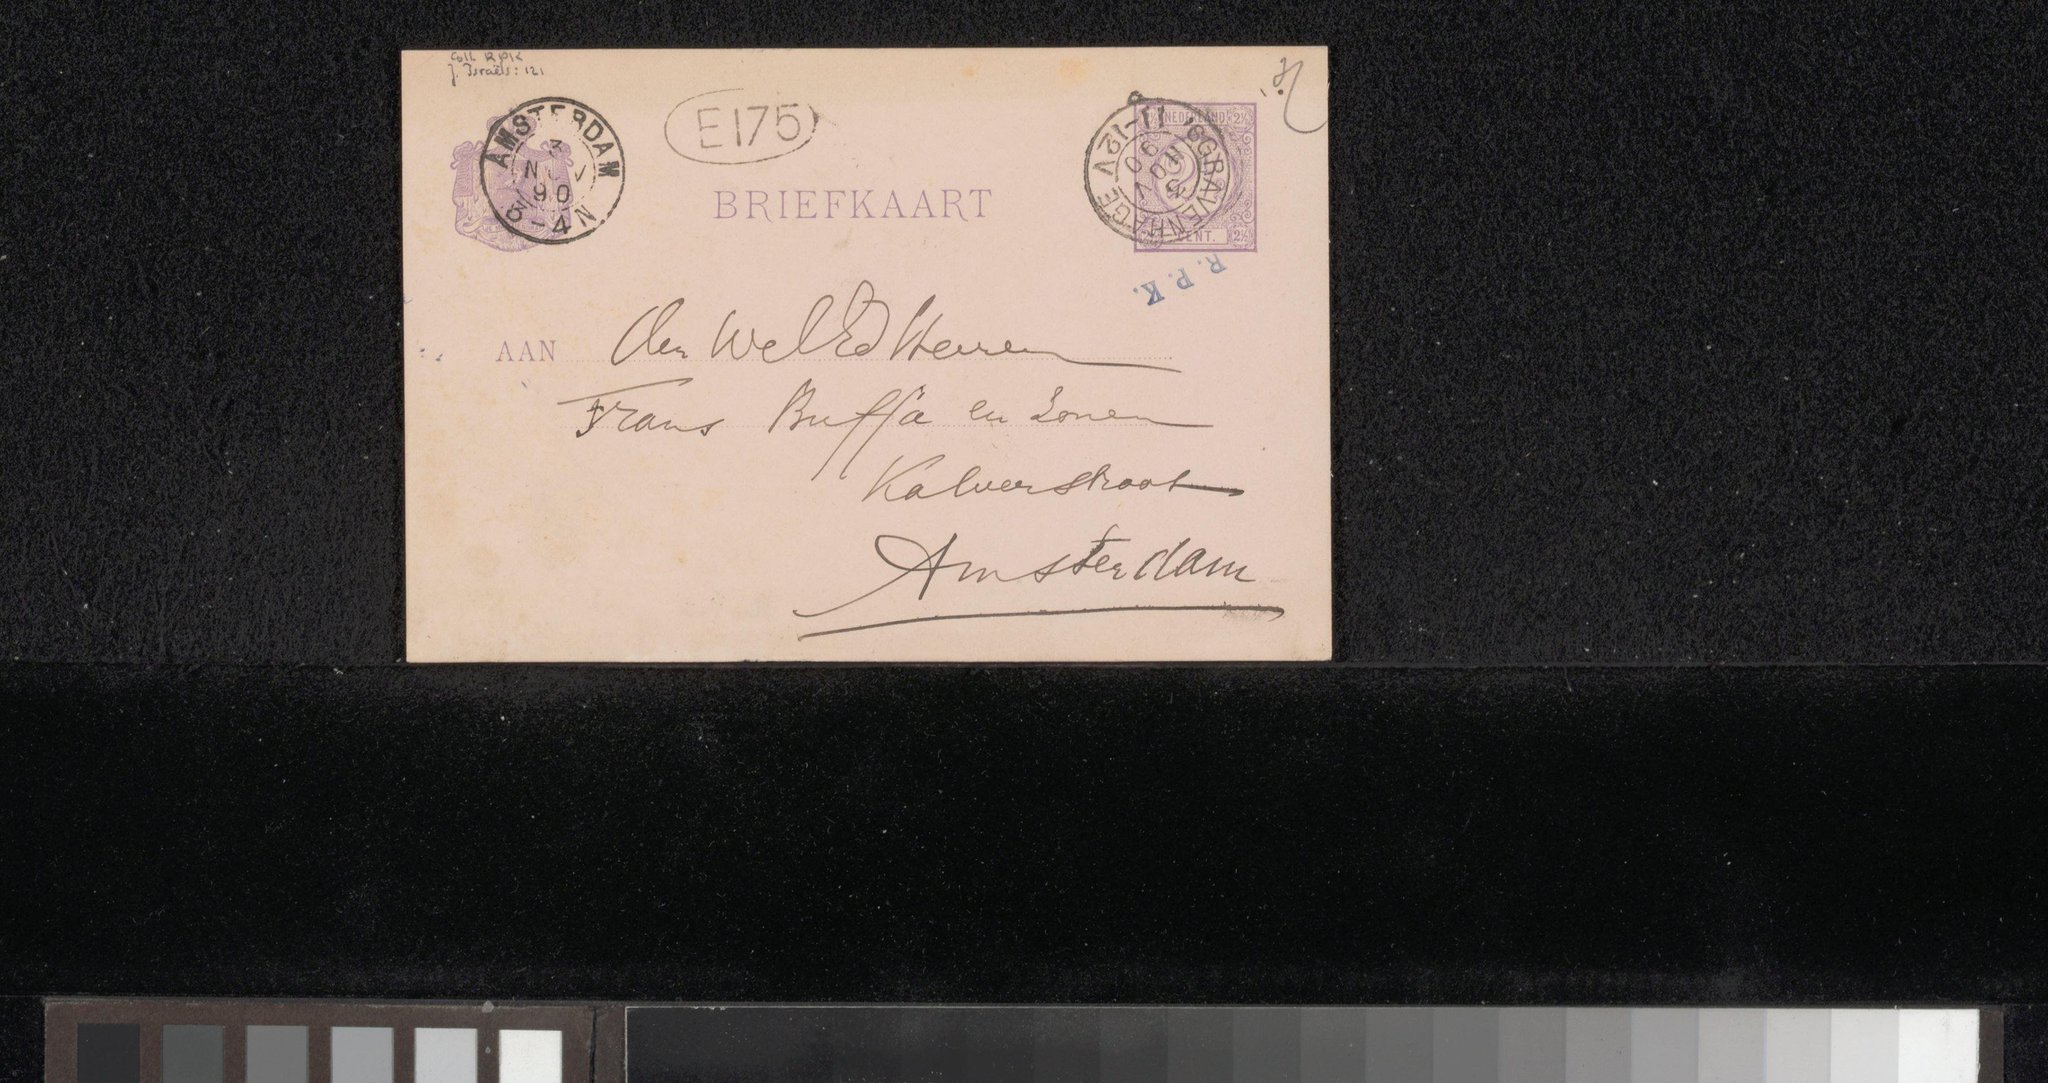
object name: postcard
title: Briefkaart aan Filippo Tessaro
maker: jozef israëls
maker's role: draughtsman, painter, print maker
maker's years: 1824-1911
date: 1890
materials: cardboard, ink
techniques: pen, writing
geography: the hague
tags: amsterdam, publisher, the graphic arts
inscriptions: collector's mark: Lugt 2233